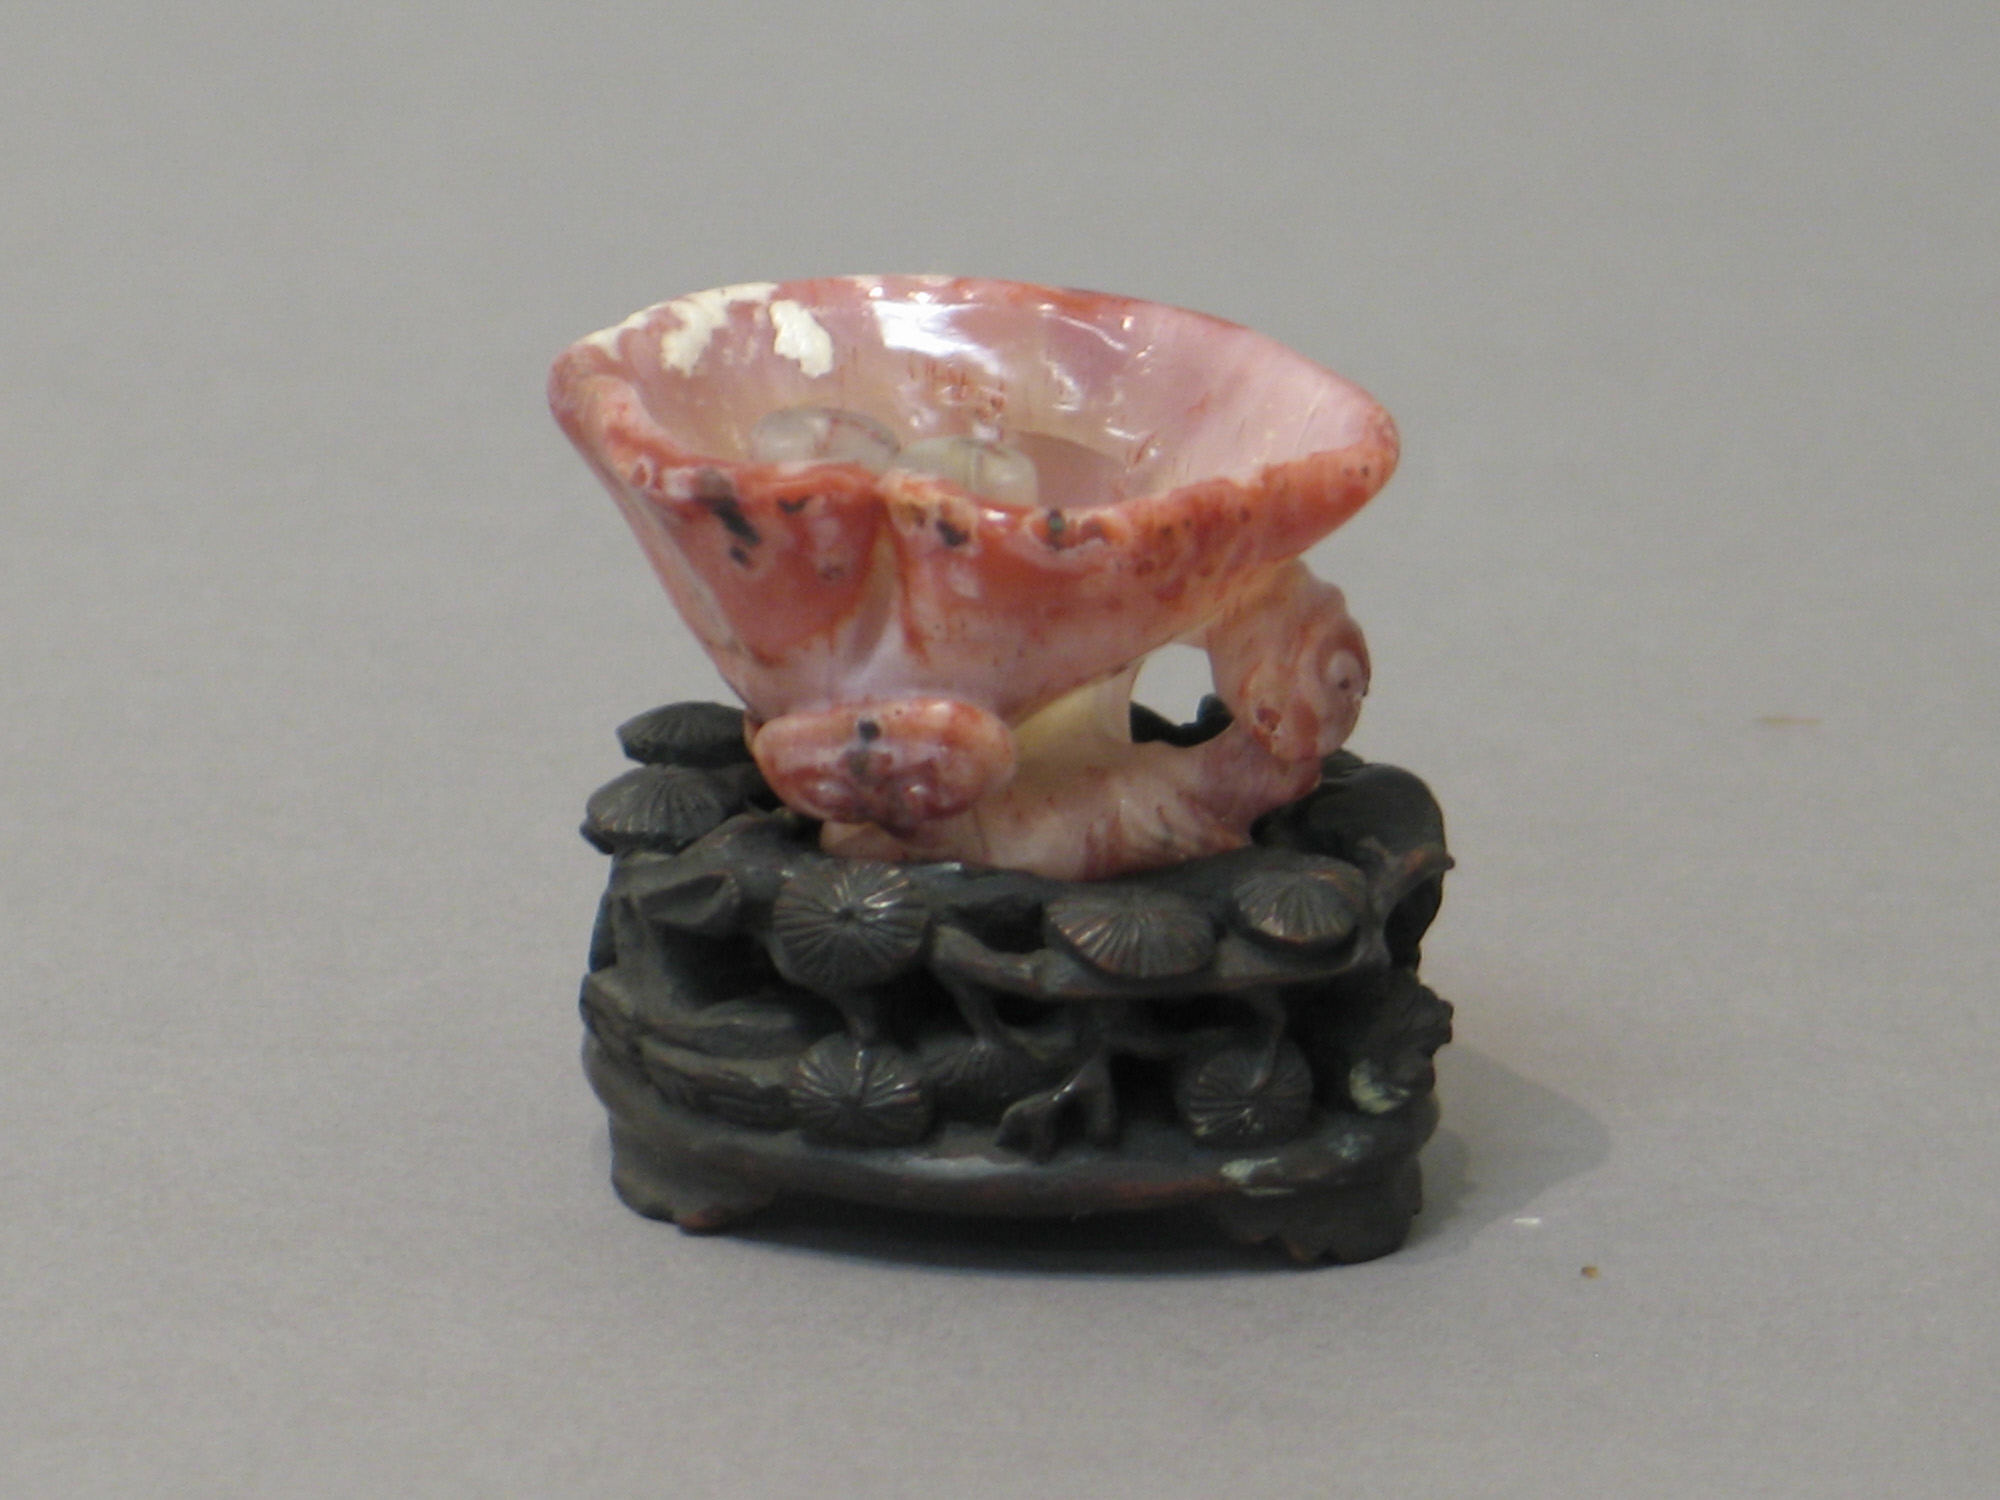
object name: cup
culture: chinese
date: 1701-1800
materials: stone, gemstone